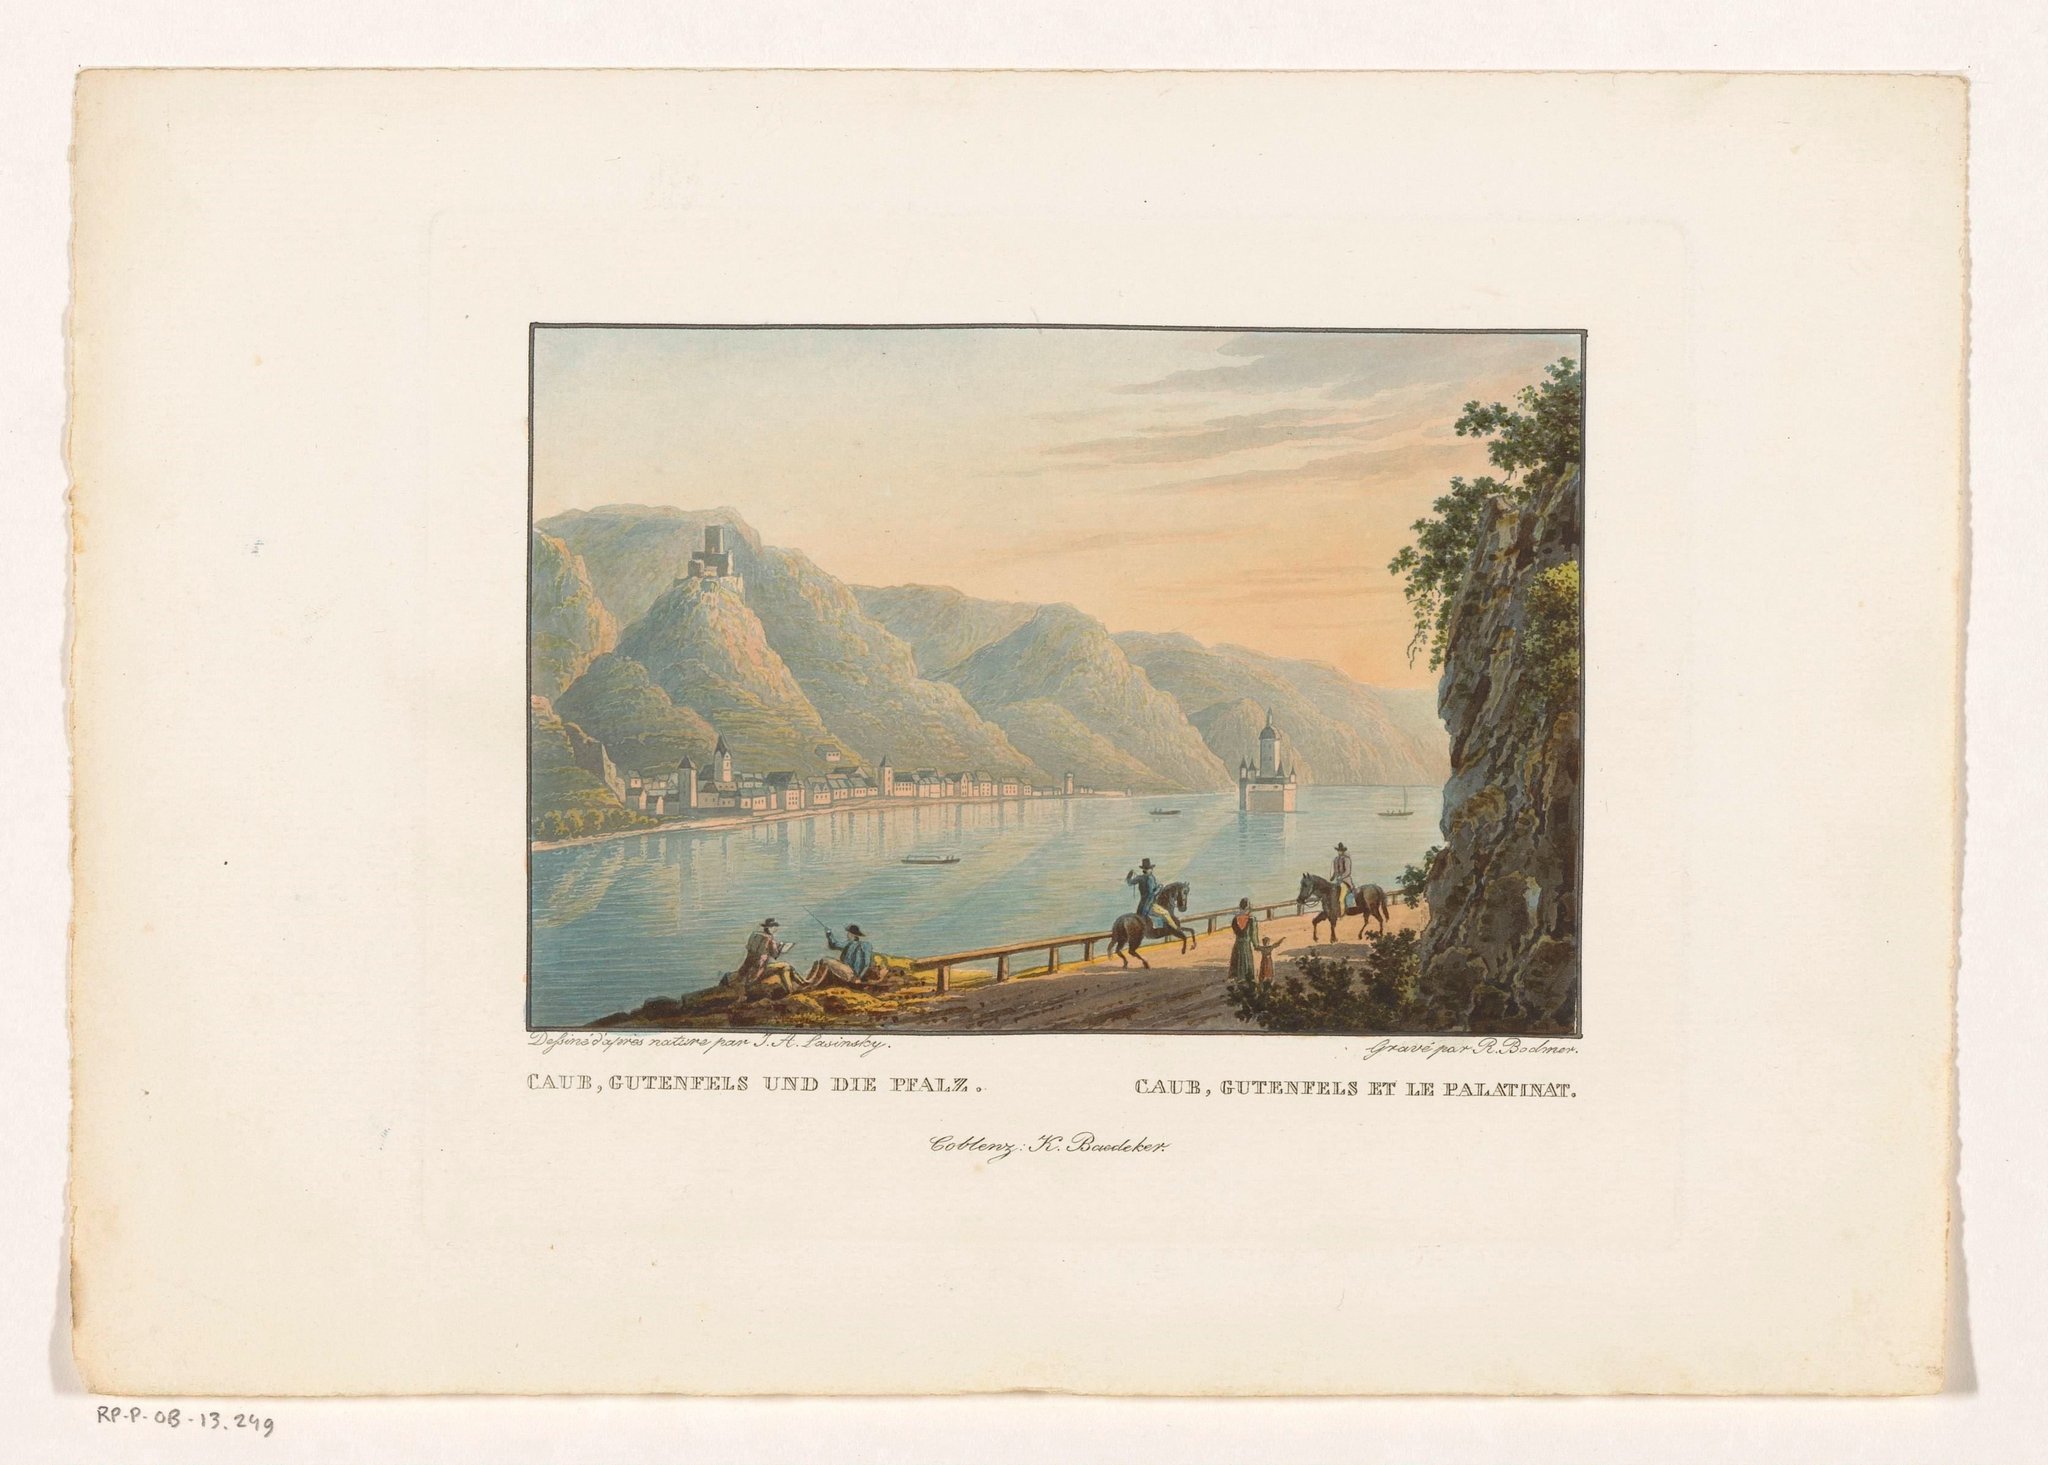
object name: print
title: Gezicht op Kaub met de burchten Gutenfels en Pfalzengrafenstein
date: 1832-1872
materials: paper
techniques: hand coloring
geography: zurich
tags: castle, river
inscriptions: collector's mark: Lugt 2228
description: Vanaf 1828 verschenen bij Franz Friedrich Röhling in Koblenz verschillende uitgaven met prenten van burchten en kastelen gelegen langs de Rijn, vervaardigd door Rudolf Bodmer naar tekeningen van Adolf Lasinsky. Vanaf 1832 verschenen deze publicaties bij Karl Baedeker, die het fonds van Röhling had overgenomen.